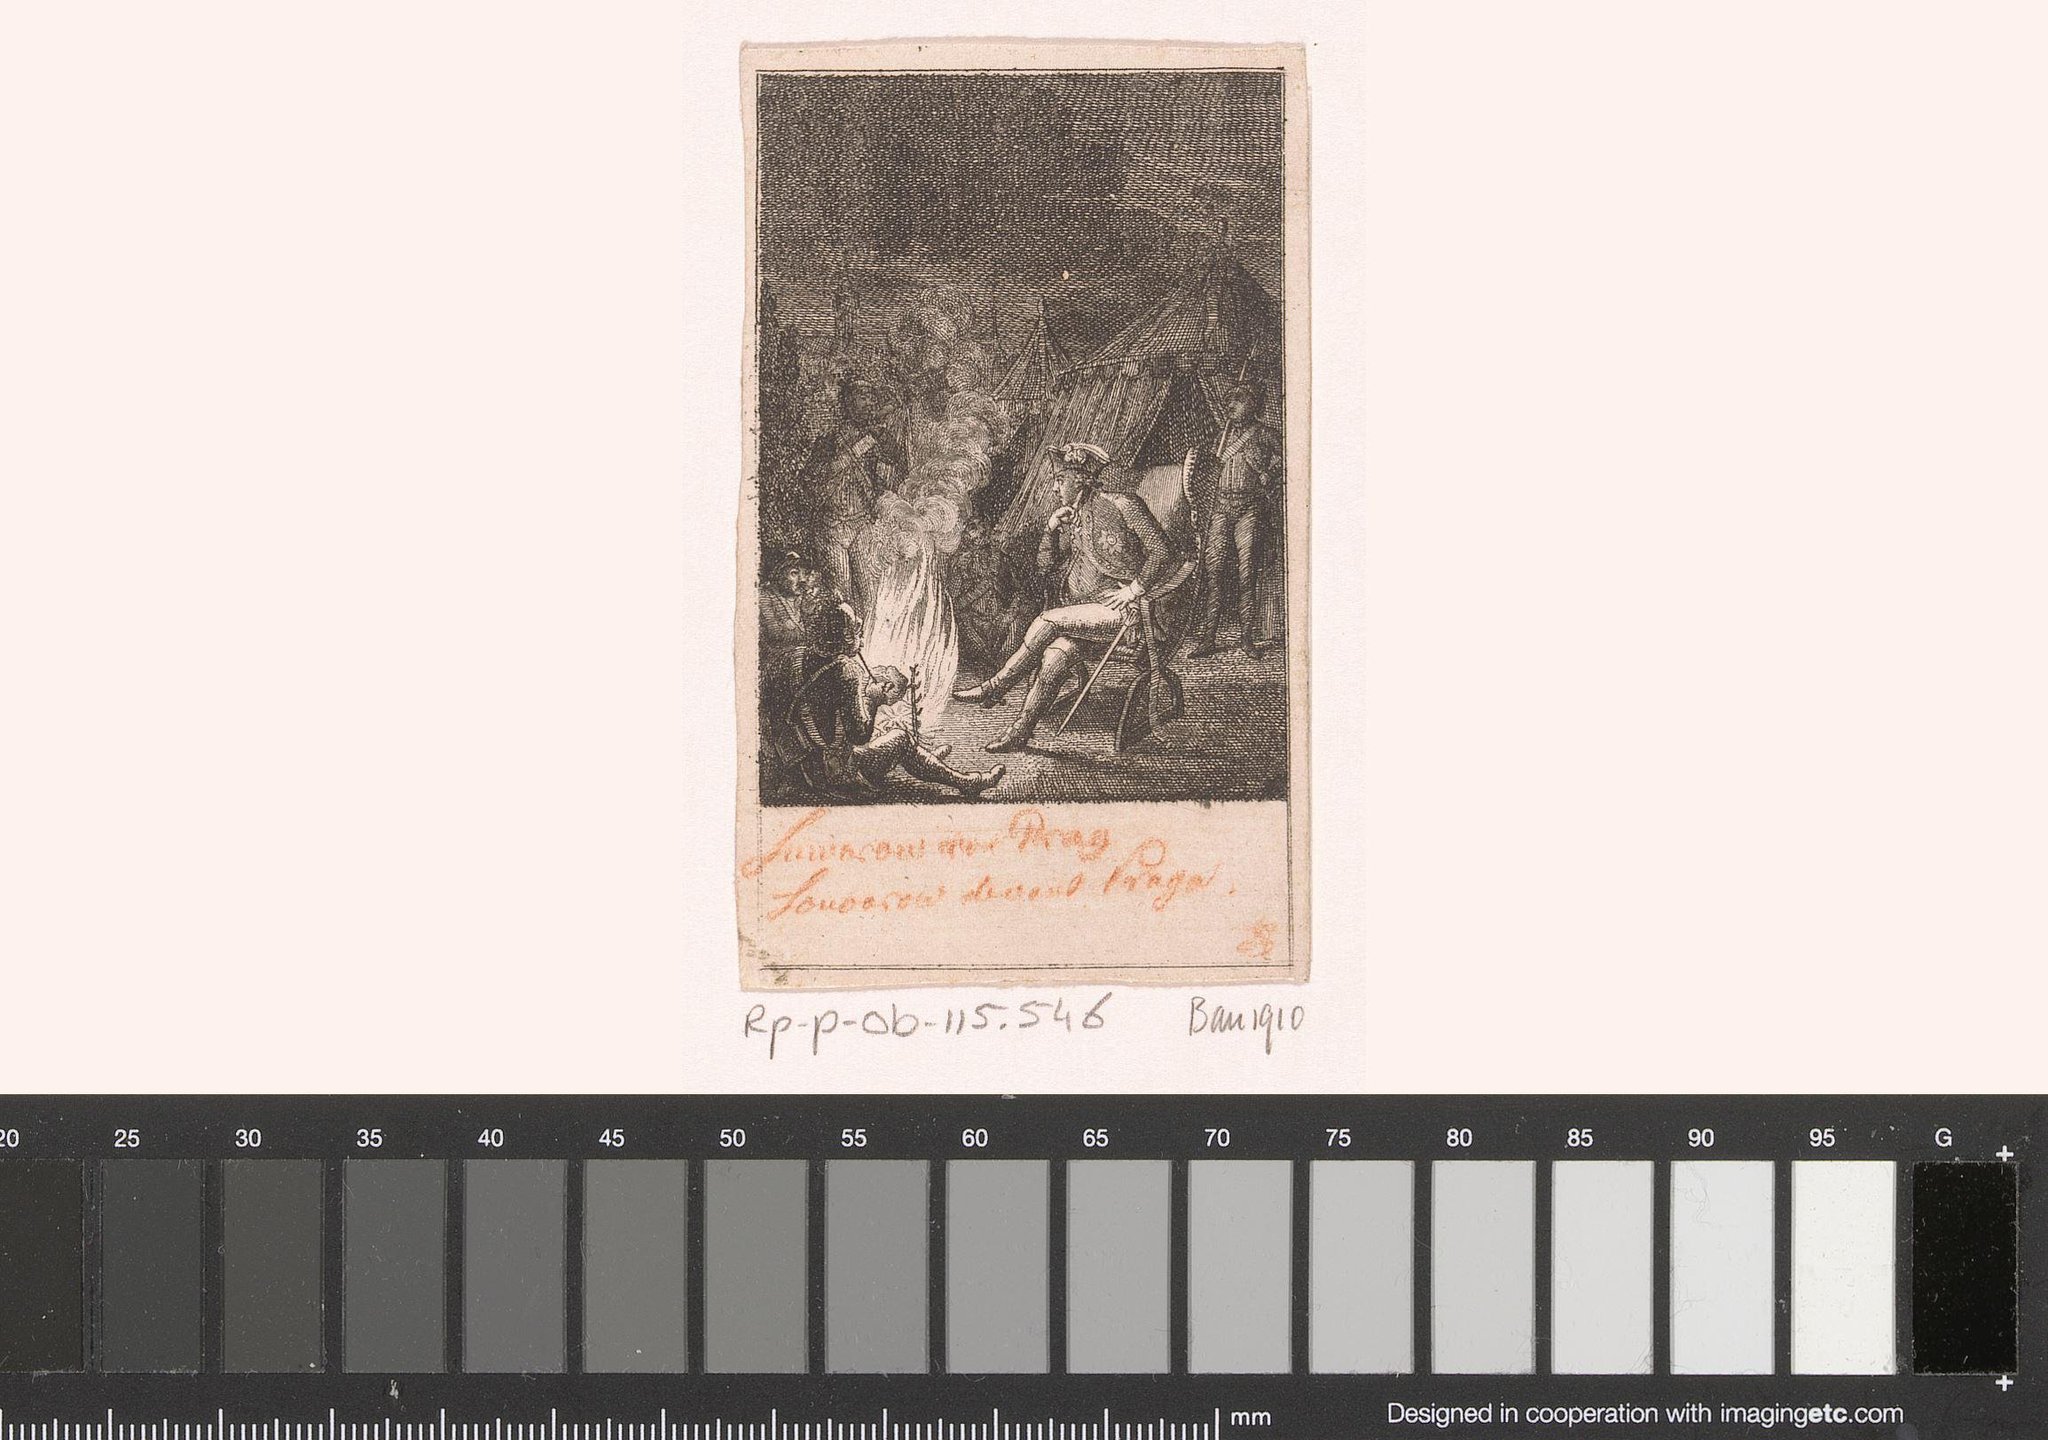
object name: print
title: Alexander Suwarow zit bij het vuur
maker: daniel nikolaus chodowiecki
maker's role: draughtsman, print maker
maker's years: 1726-1801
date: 1797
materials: paper, pencil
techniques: etching, writing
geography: berlin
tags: catharina de grote, (military) camp with tents, history, camp-fire; watch-fire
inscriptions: collector's mark: Lugt 2228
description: Latere staat gebruikt voor: Historisch-genealogischer Kalender auf das Gemeinjahr 1798. Katharina II. Ein historischer Versuch (...). Berlijn: Johann Friedrich Unger, [1797].